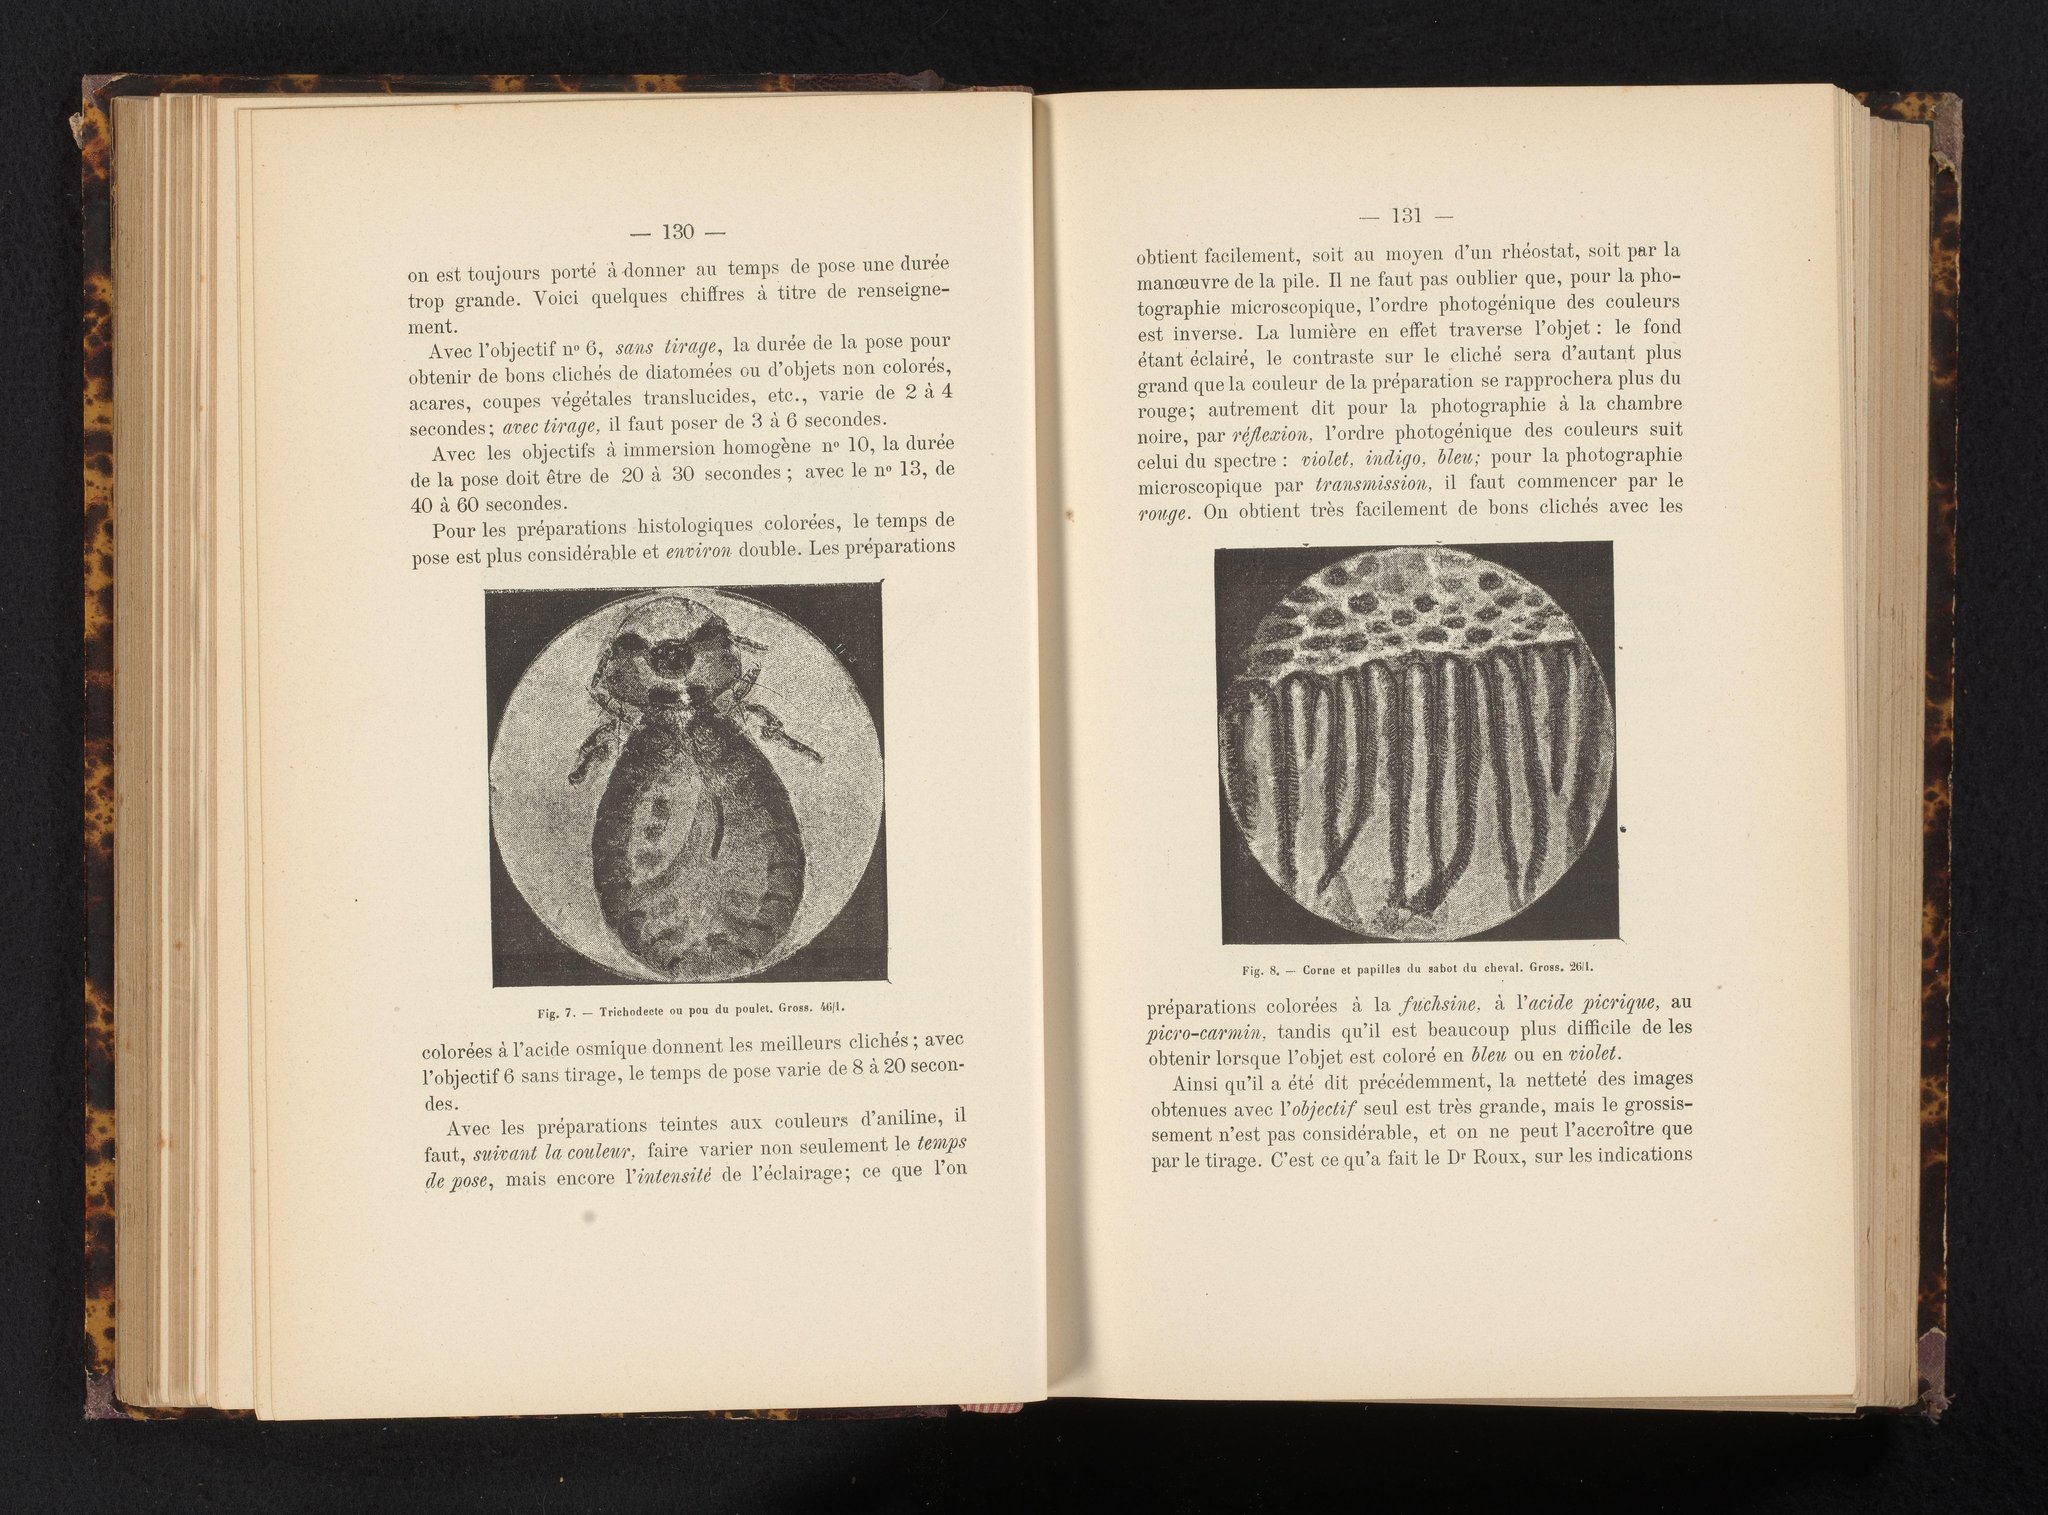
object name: page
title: Hoef van een paard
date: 1881-1886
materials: paper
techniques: autotype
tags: horse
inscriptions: inscription: ‘Fig. 8. (...) Gross. 26/1.’